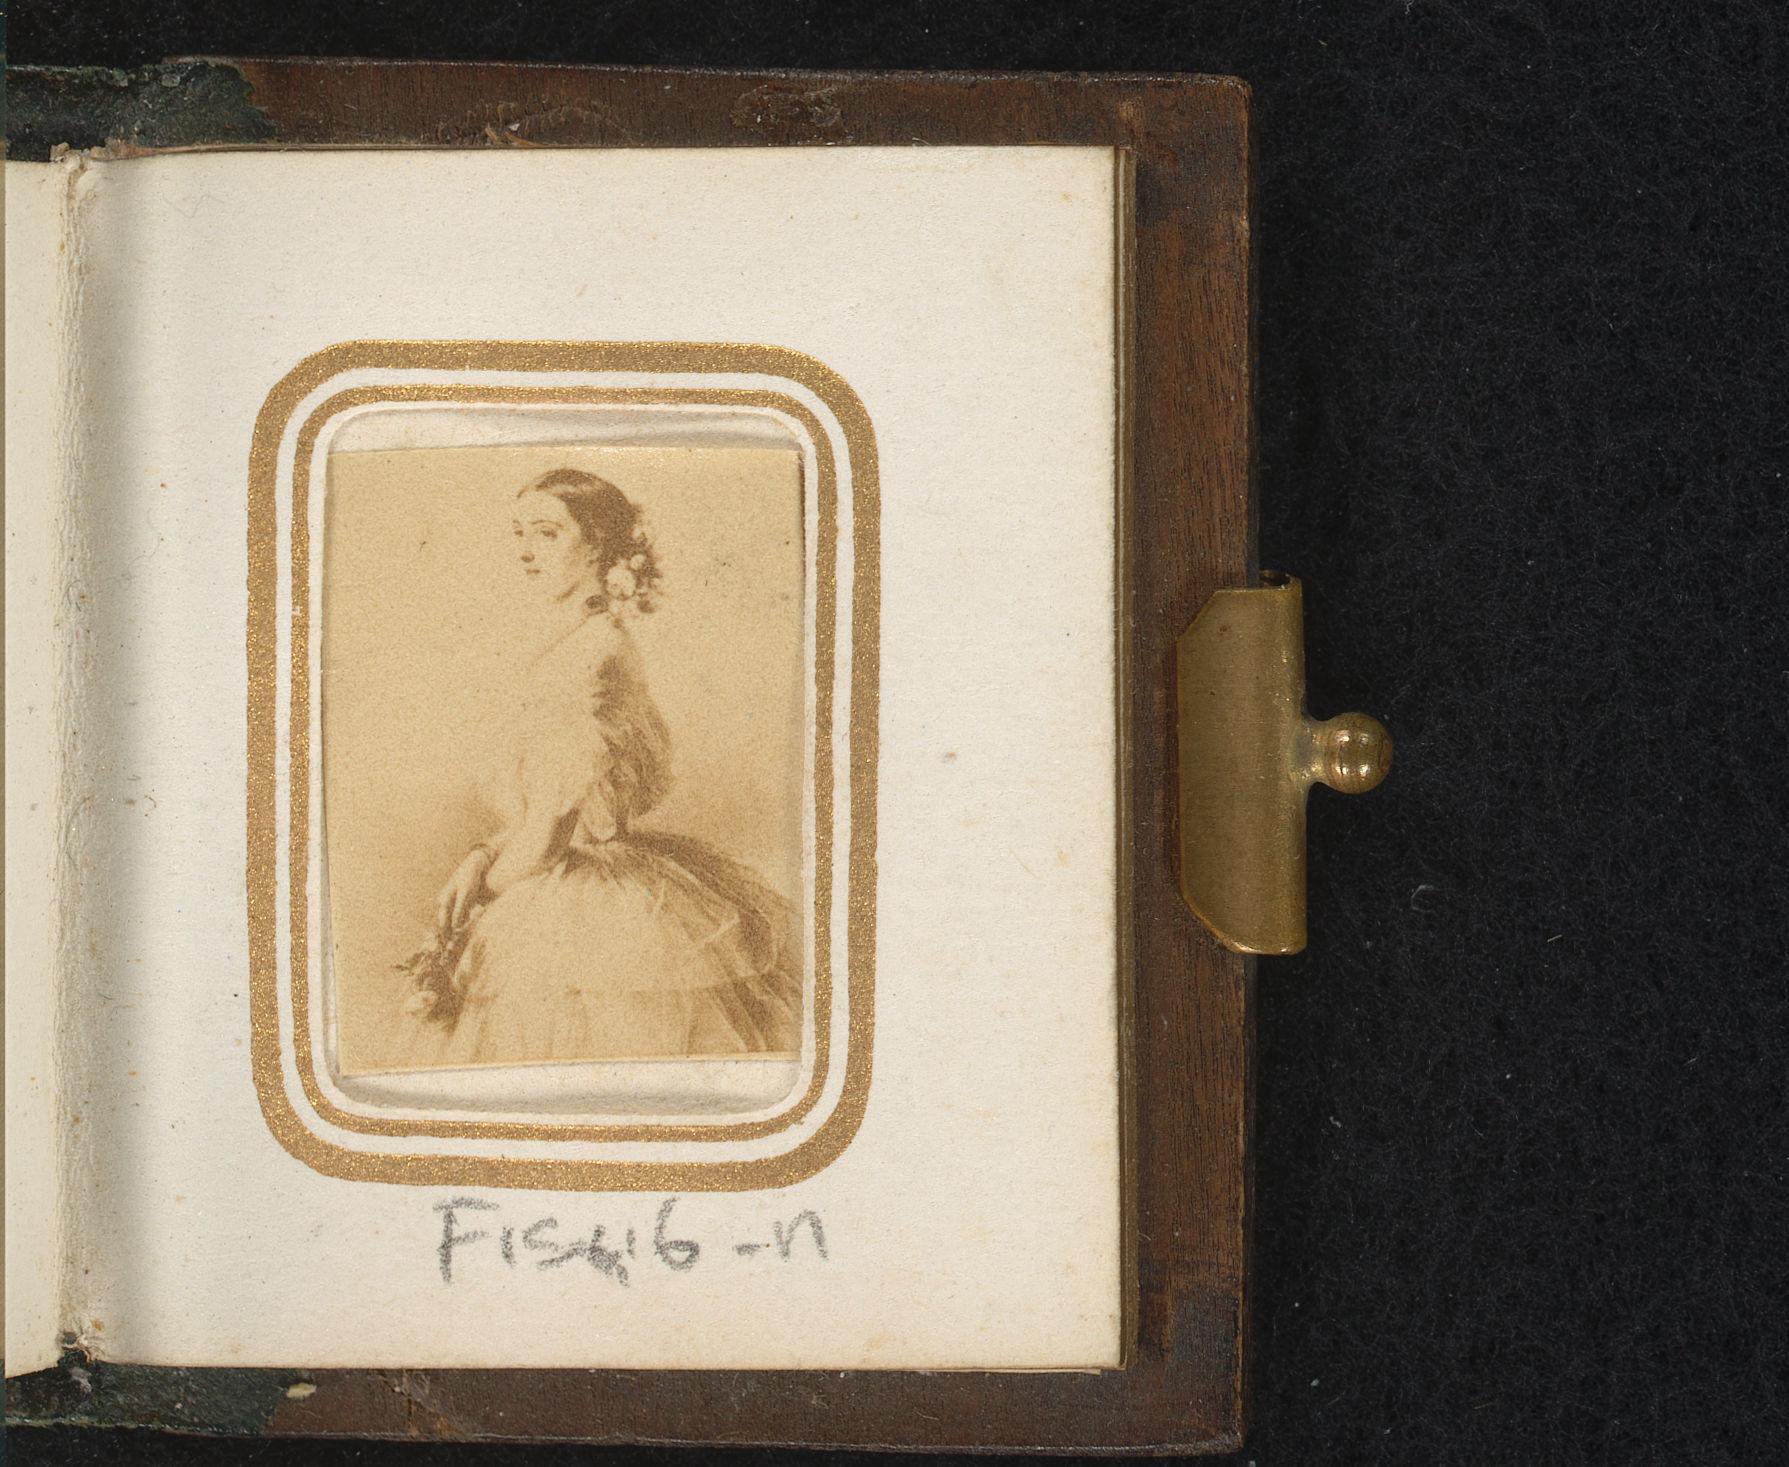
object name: album leaf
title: Fotoreproductie van een portret van een jonge vrouw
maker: Anonymous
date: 1851-1900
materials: paper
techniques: albumen print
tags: youth, adolescent, anonymous historical person portrayed